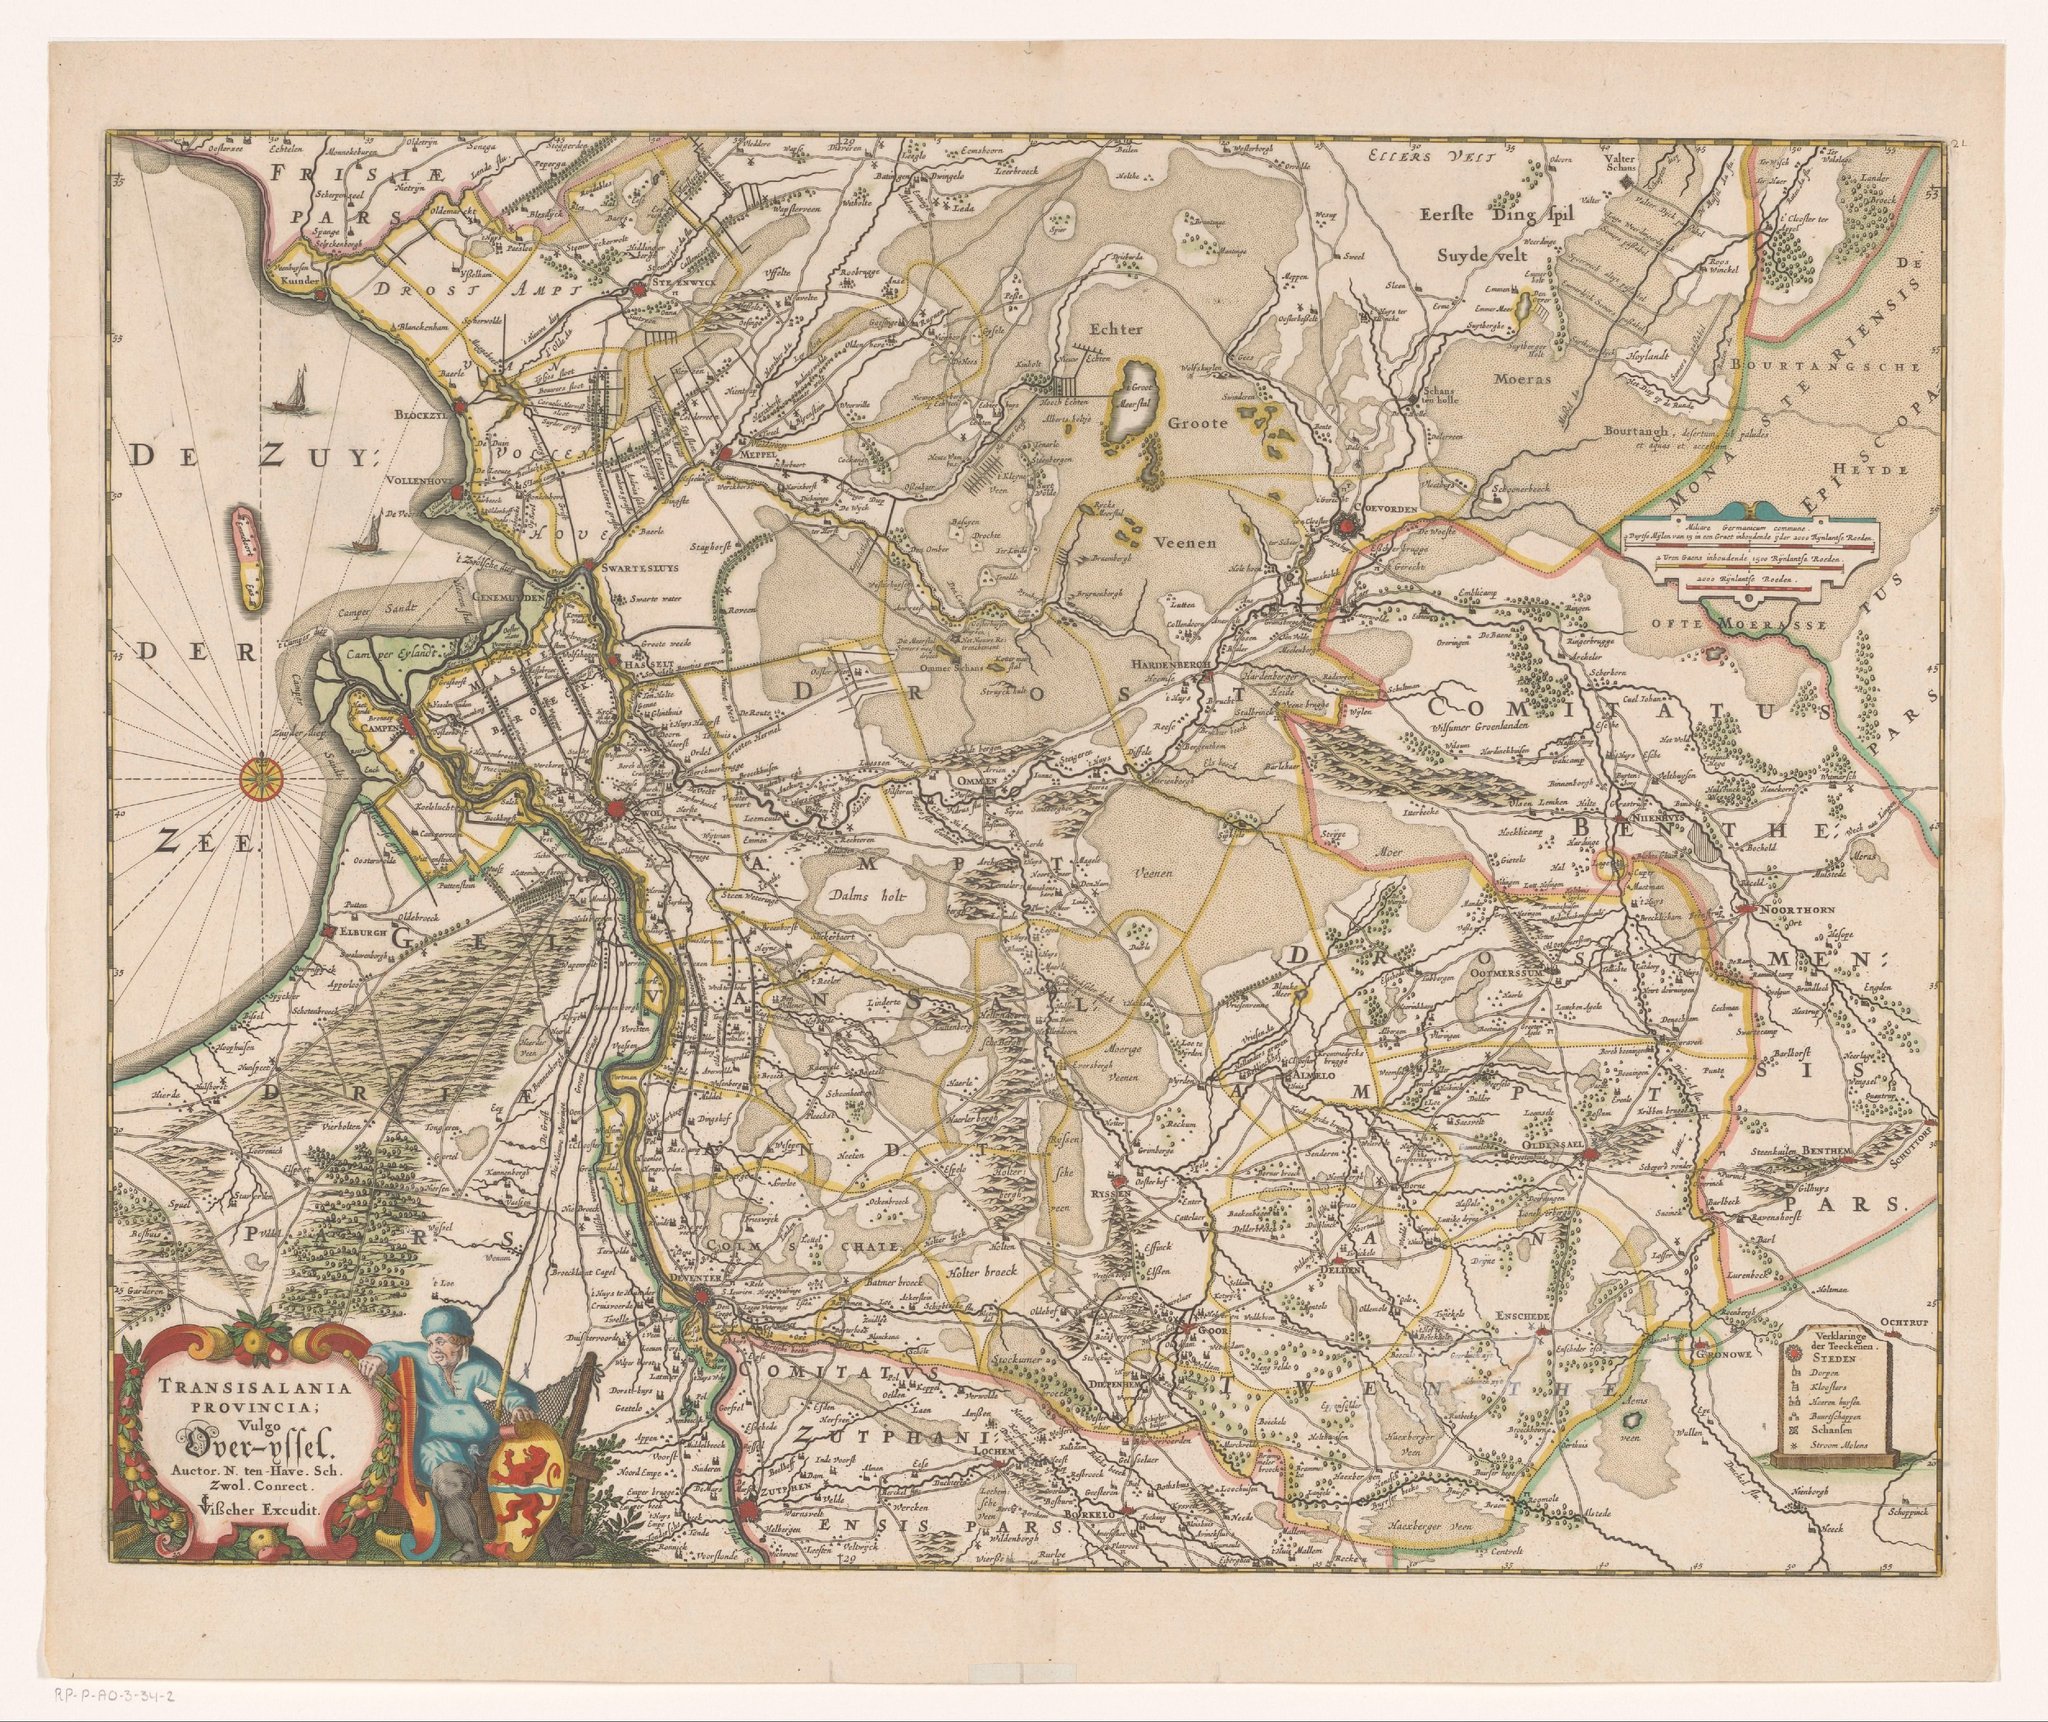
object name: print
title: Transisalania provincia; vulgo Over-yssel (...)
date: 1640-1652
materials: paper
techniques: engraving, etching, hand coloring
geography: amsterdam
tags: coat of arms (as symbol of the state, etc.), maps of separate countries or regions, fisherman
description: Linksonder de titelcartouche, daarnaast een visser en het wapen van Overijssel. Rechtsboven drie schaalstokken: Miliare Germanicum commune / 2 Duytse mijlen van 15 in een graet inhoudende ijder 2000 Rijnlantse roeden, 2 uren gaens inhoudende 1500 Rijnlantse roeden, 2000 Rijnlantse roeden. Rechtsonder een legenda. Gradenverdeling langs de randen.